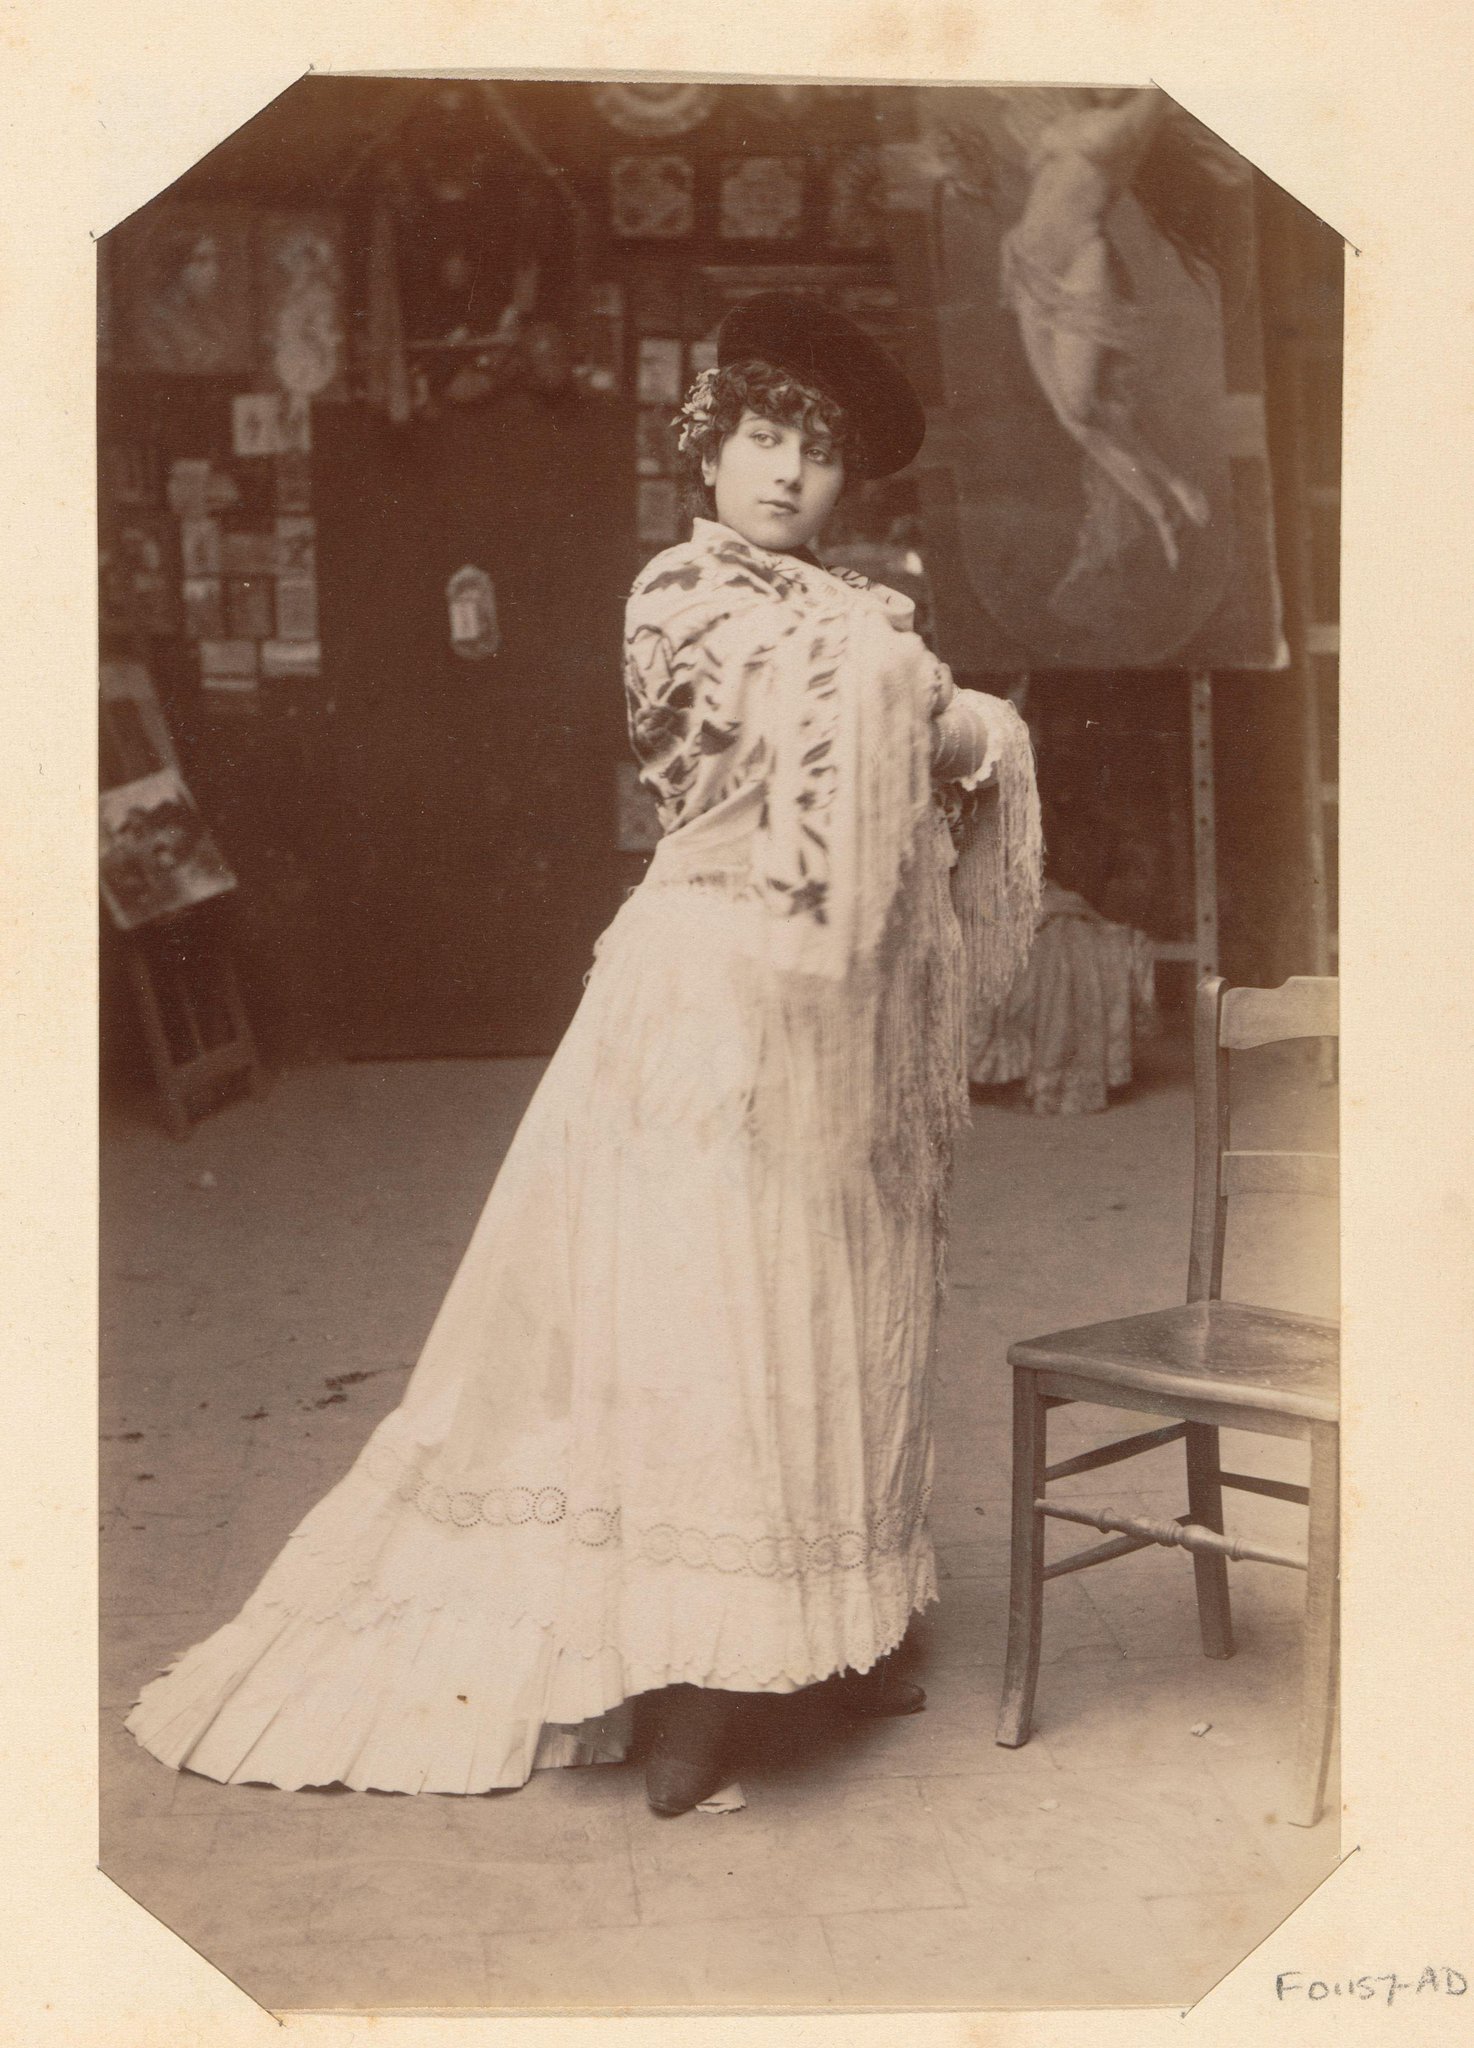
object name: photograph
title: Vrouw in klederdracht uit Andalusië en Valencia in danshouding in atelier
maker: Anonymous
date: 1885-1892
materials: photographic support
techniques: albumen print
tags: adult woman, folk costume, regional costume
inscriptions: annotation: ‘van Andalusia & Valencia’